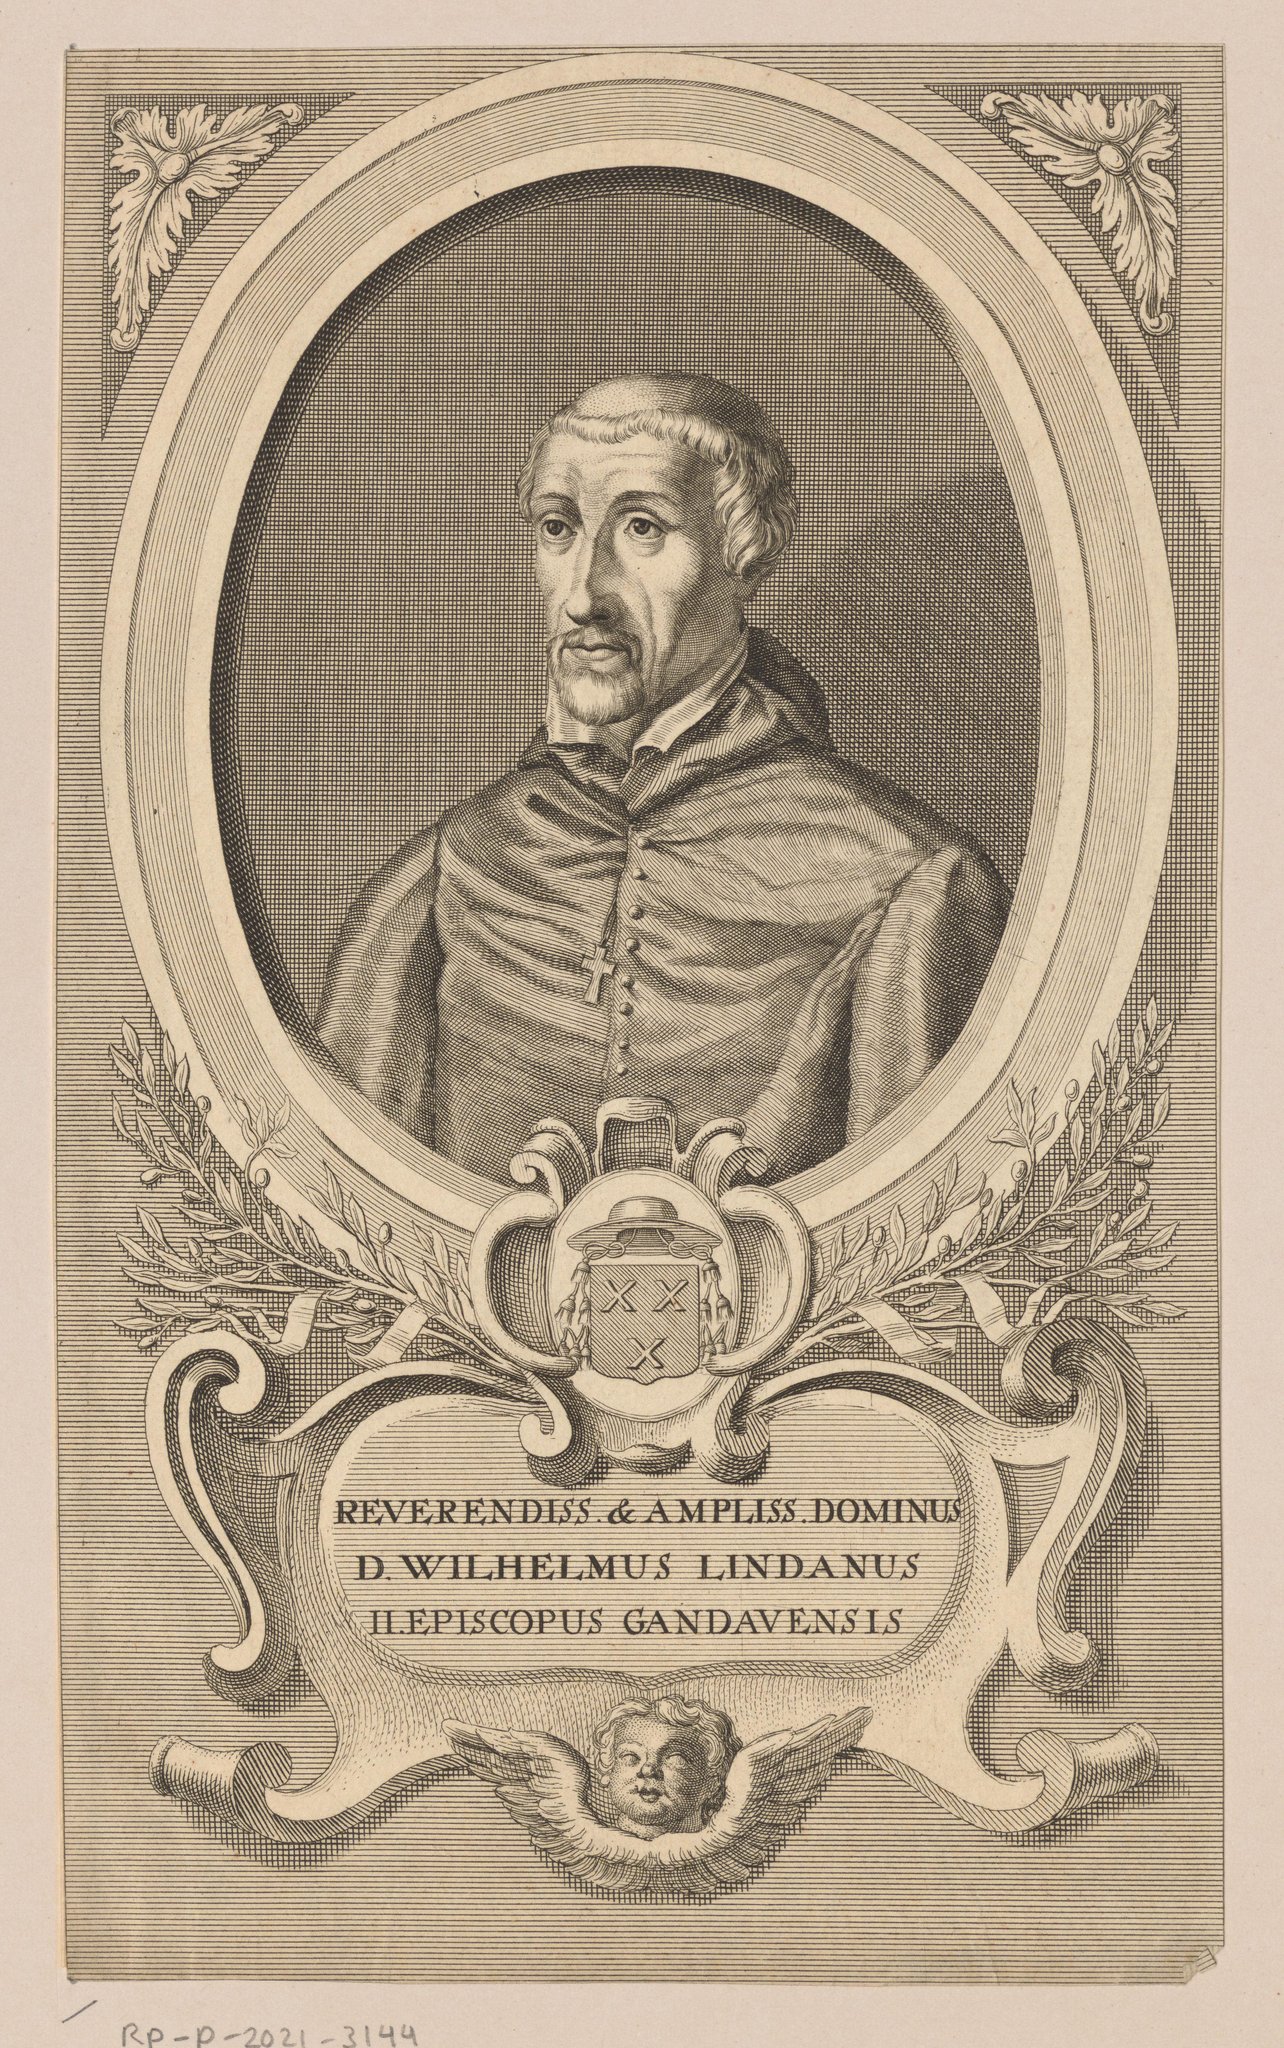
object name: book illustration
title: Portret van Guilielmus Damasus Lindanus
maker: Anonymous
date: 1732-1735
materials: paper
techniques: engraving, etching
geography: the hague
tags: dordrecht, ghent, cherubs, i.e. children's heads with wings, archbishop, bishop, etc. (roman catholic), ornament ~ medallion, historical persons, armorial bearing, heraldry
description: Prent waarschijnlijk uit: Sanderus, Antonius. Flandria Illustrata (...). Den Haag: Christiaan van Lom, 1732, dl. 1. Of uit de latere druk uit 1735.